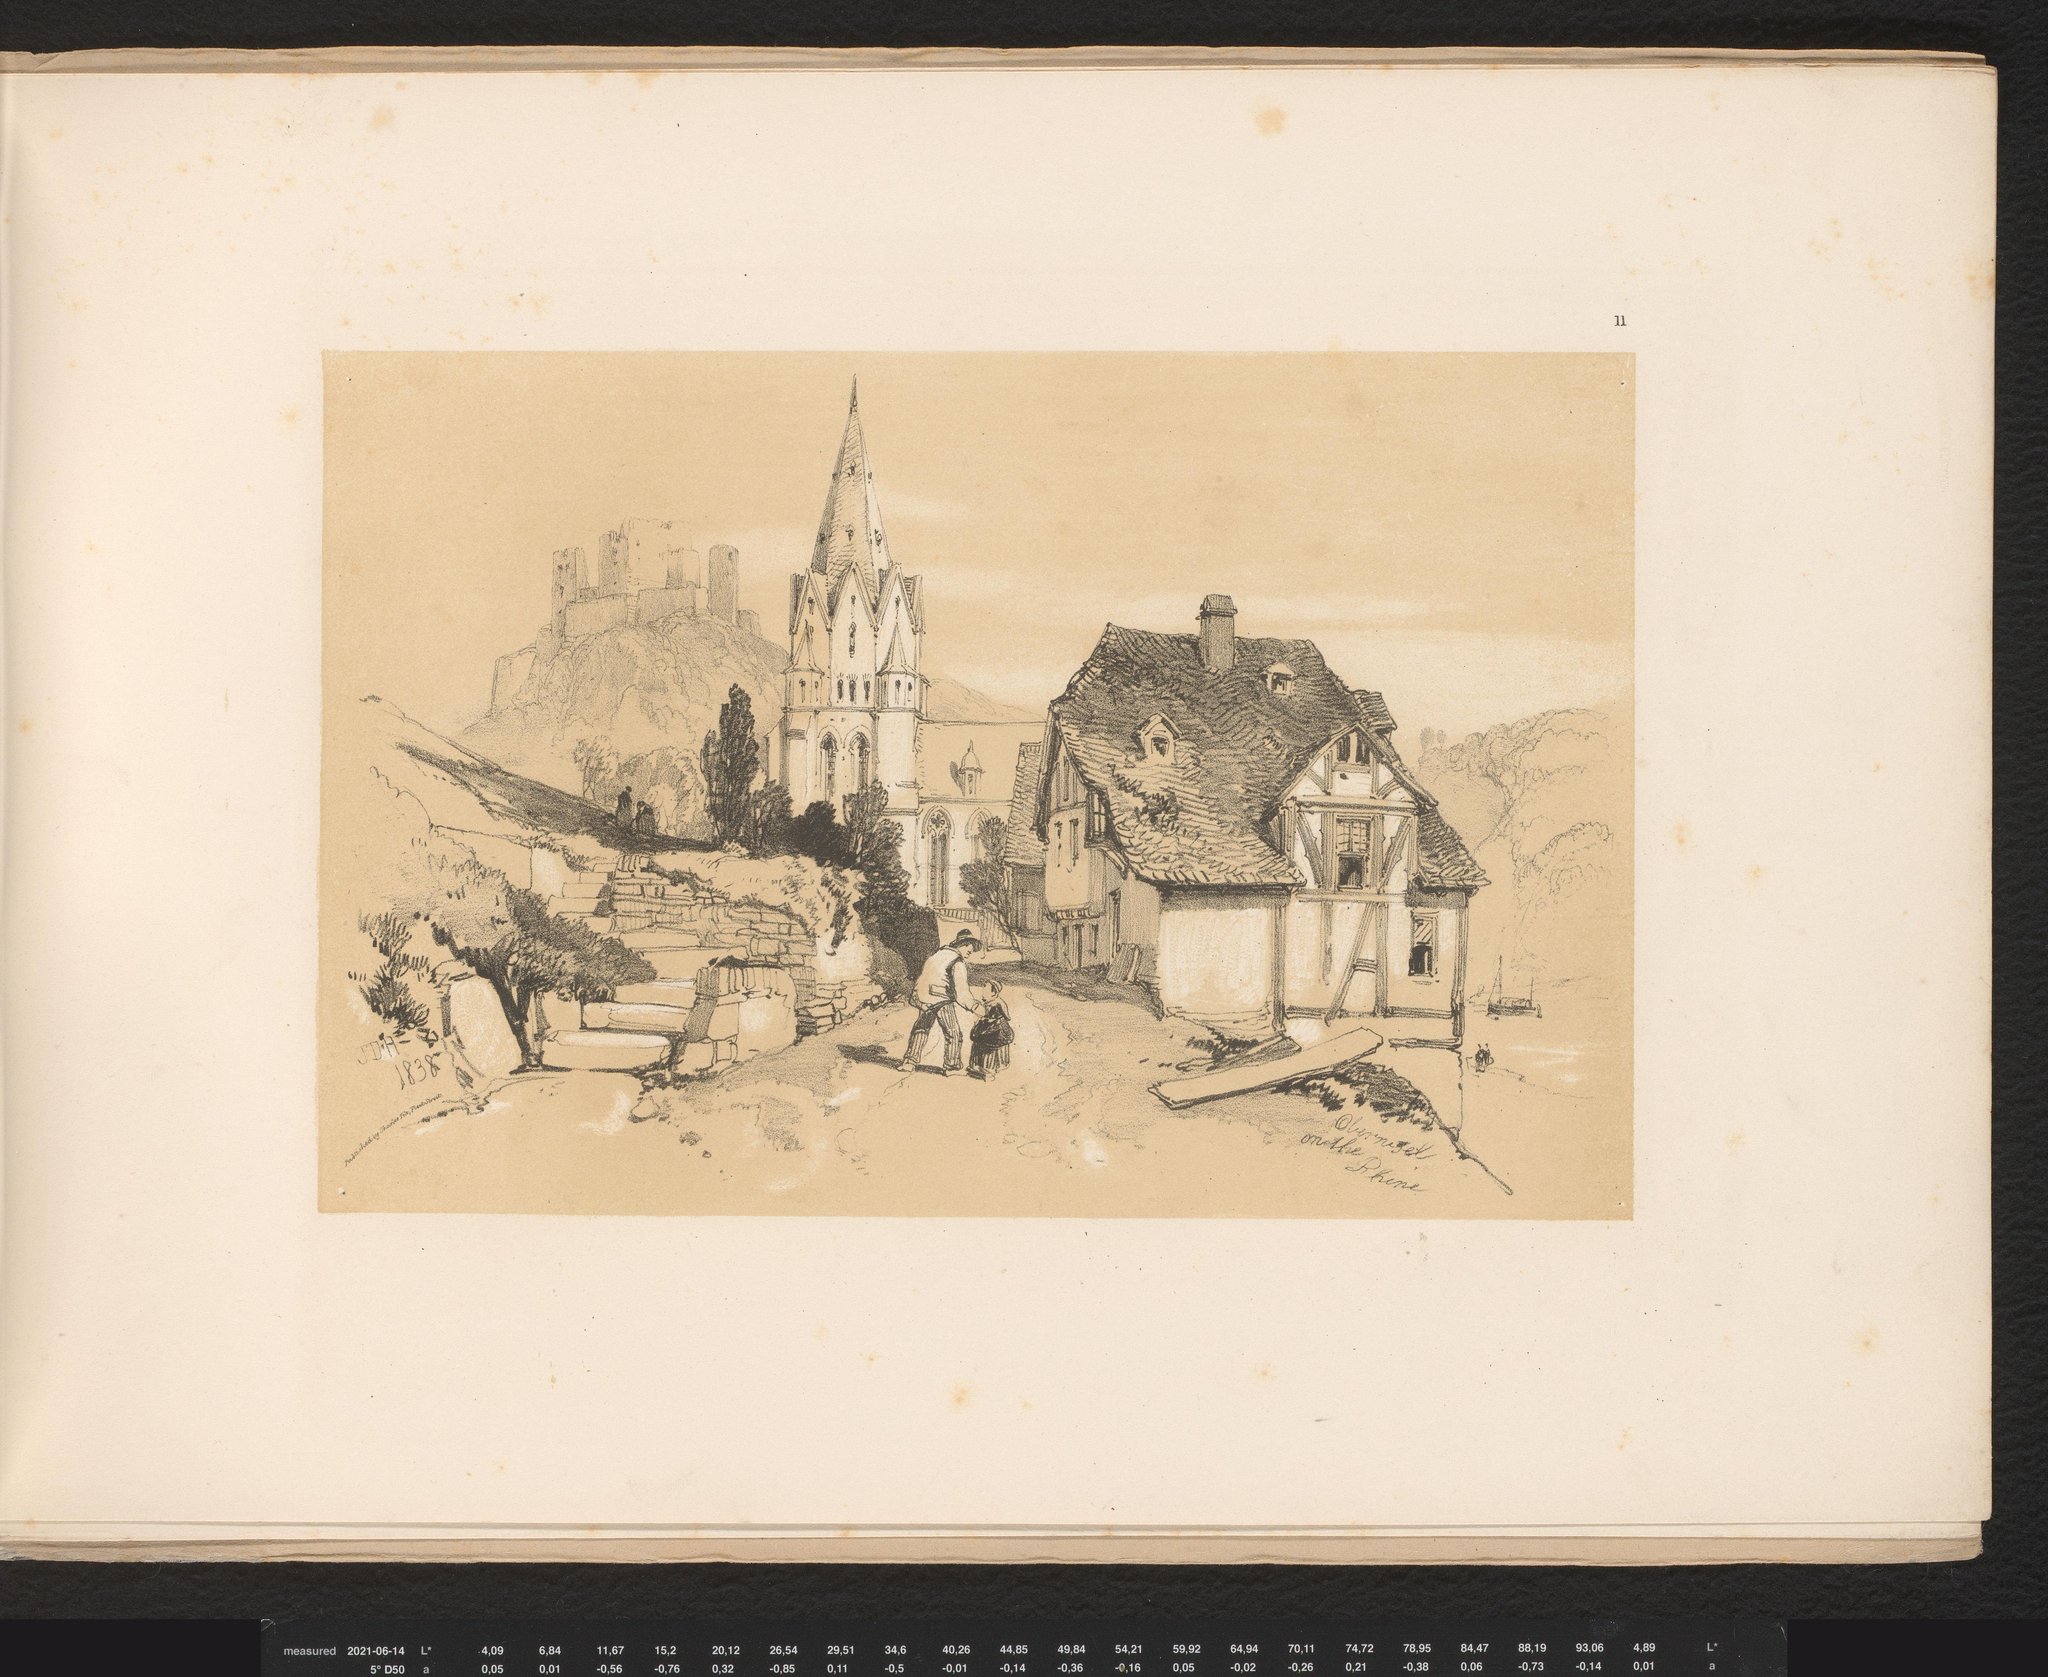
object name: print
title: Oberwesel on the Rhine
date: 1838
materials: paper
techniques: tone lithography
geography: london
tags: village (+ city(-scape) with figures, staffage), landscapes in the temperate zone (+ landscape with figures, staffage)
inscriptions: collector's mark: Lugt 2228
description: Uitgever Charles Tilt heeft verschillende series uitgegeven over het werk van James Duffield Harding. Deze serie 'Harding's drawing book for the year MDCCCXXXVIII', bestaat uit zes delen met elk vier lithografieën.